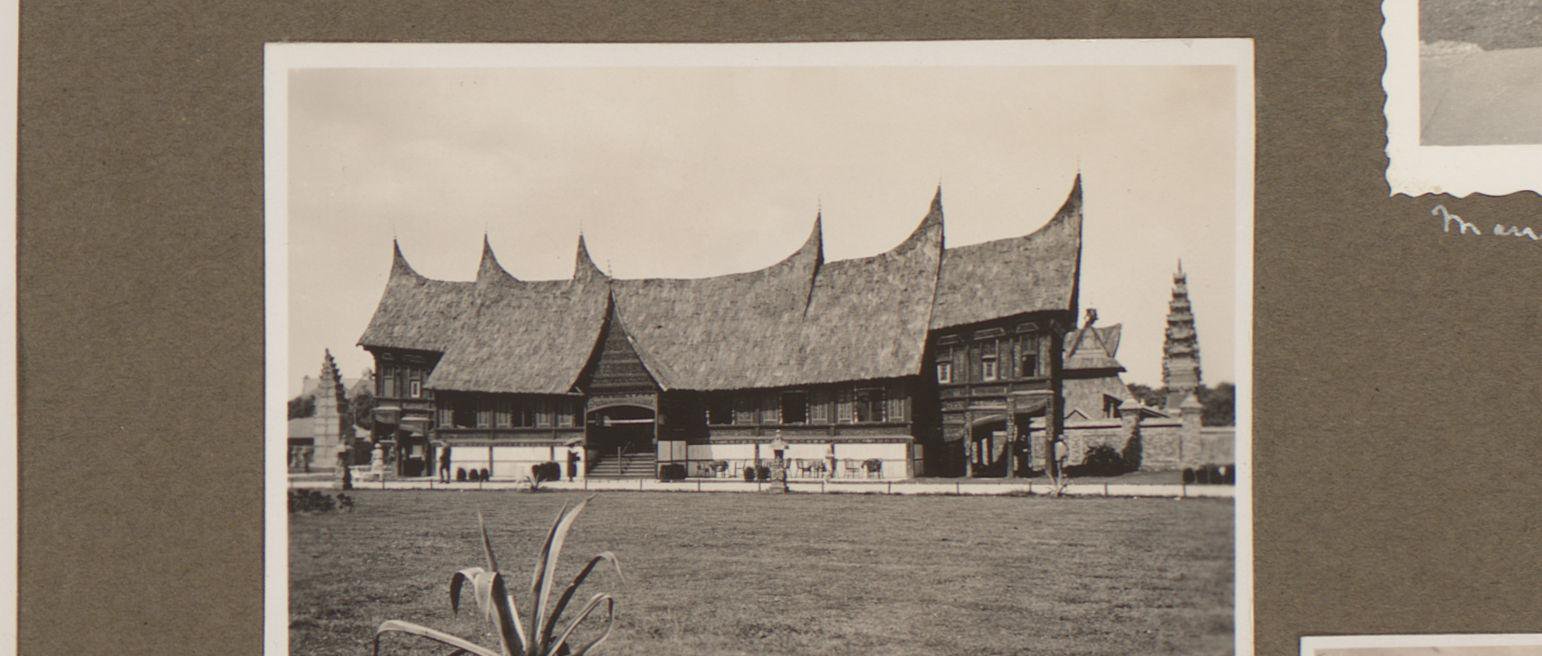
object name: photograph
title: Sumatraans huis op de Indische Tentoonstelling in Den Haag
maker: Anonymous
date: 1932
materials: paper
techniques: gelatin silver print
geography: the hague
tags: rural housing, e.g. country-house, villa, cottage, collection, exhibition, show, the hague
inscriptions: inscription: ‘Sumatra Huis’, inscription: ‘Indische Tentoonstelling/ Den Haag’